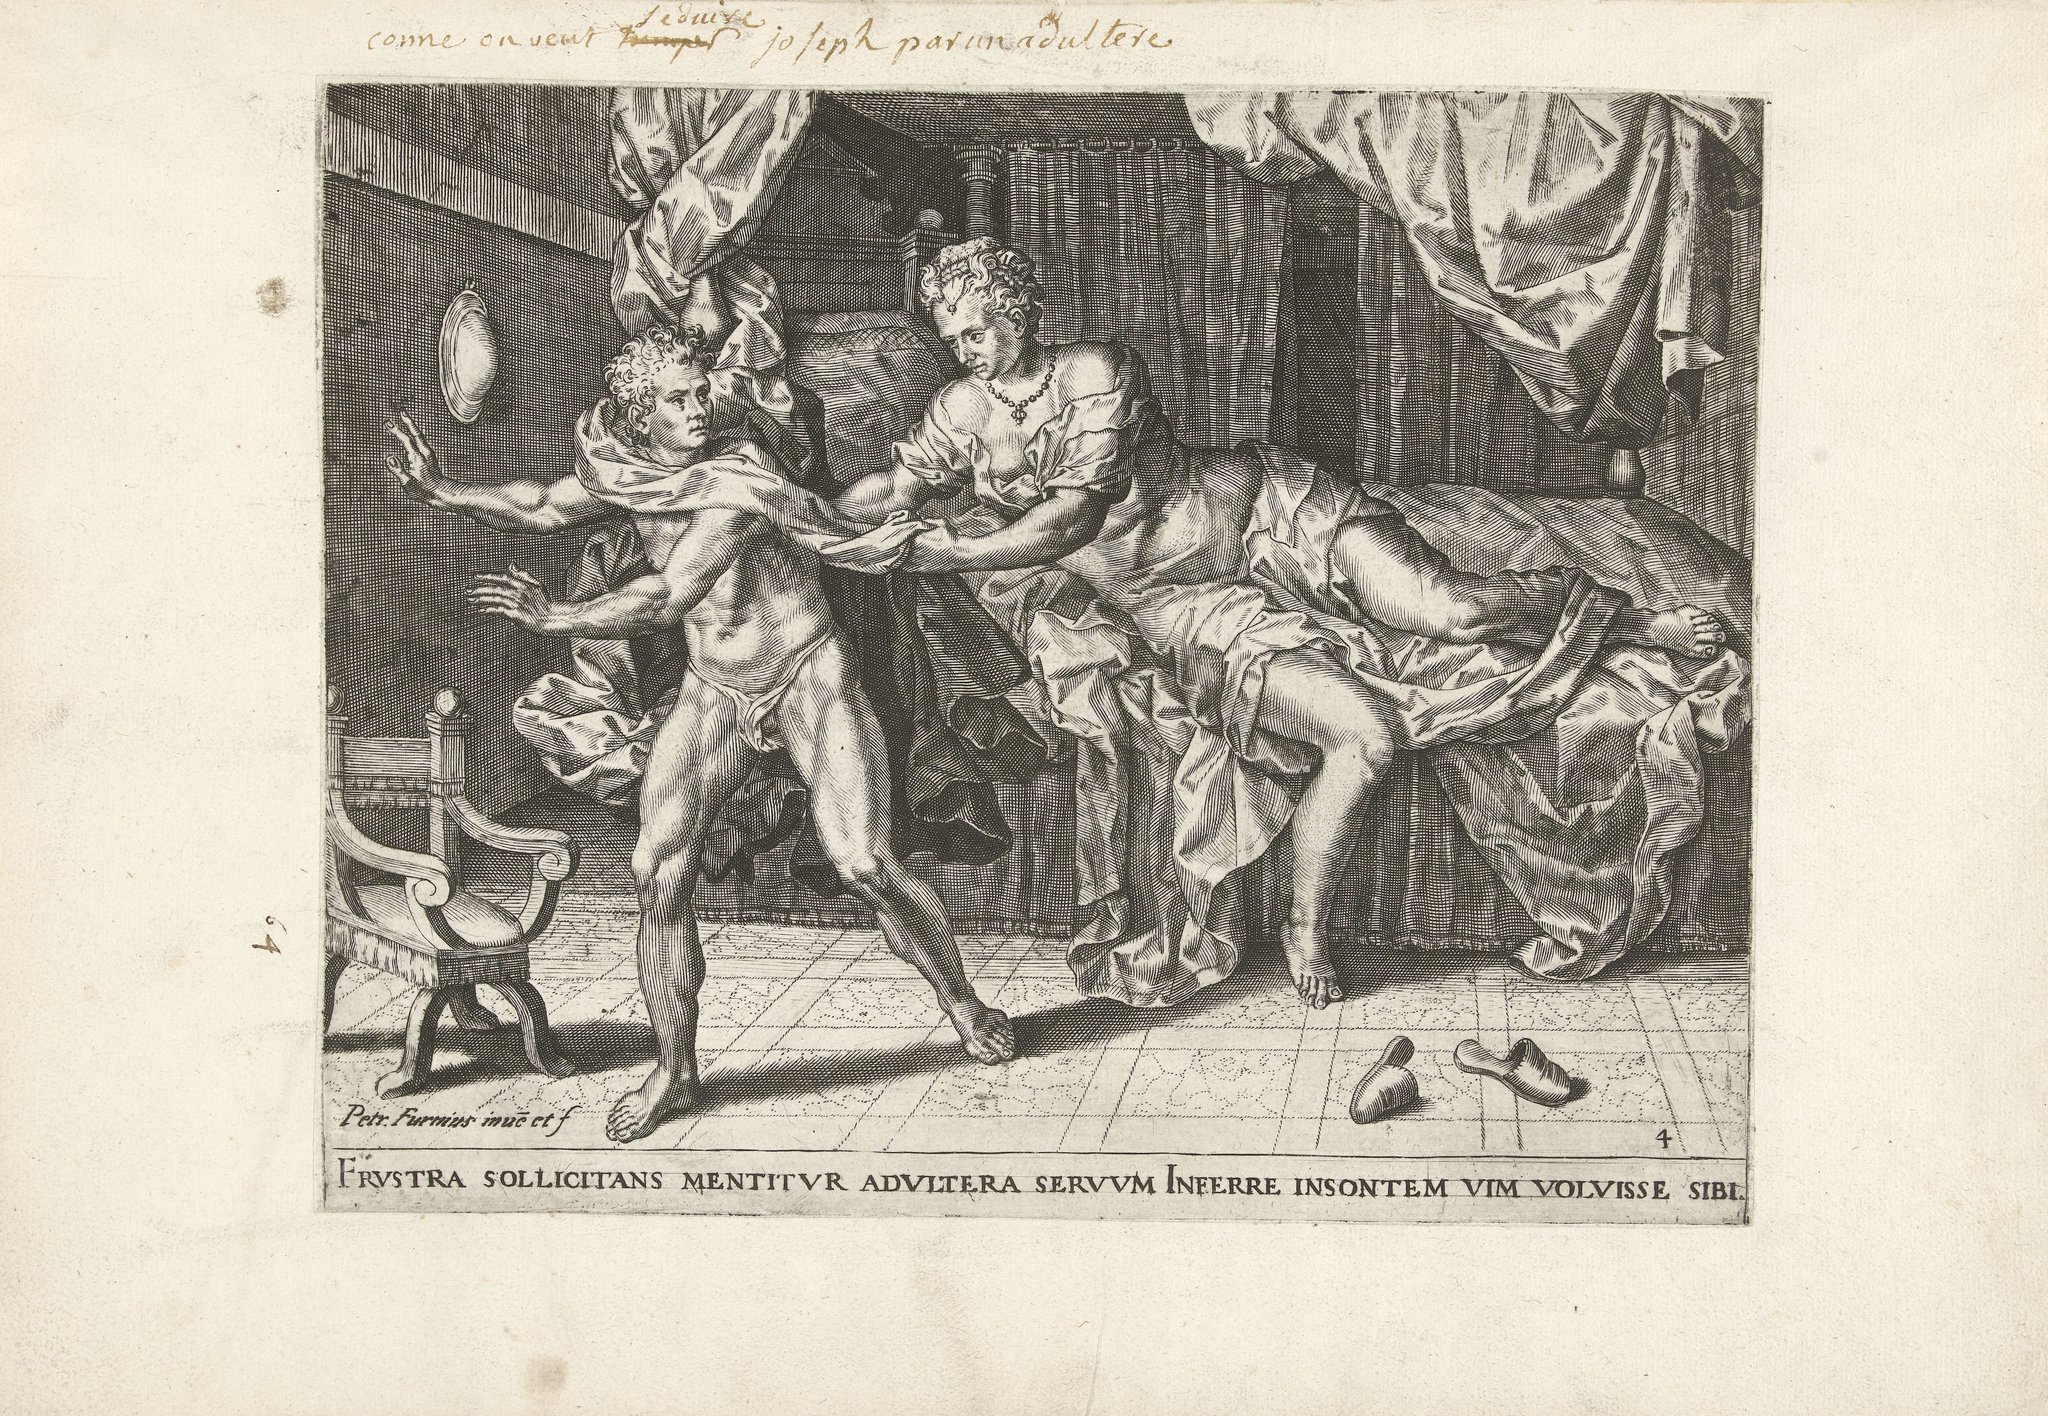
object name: print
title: Geschiedenis van Jozef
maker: pieter jalhea furnius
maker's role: print maker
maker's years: 1540-1626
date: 1572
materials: paper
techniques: engraving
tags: potiphar's wife catches joseph by his robe, usually while lying in bed; joseph escapes leaving his cloak behind in her hands (possibly with a naked child lying in a crib), bed with tester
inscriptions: collector's mark: Lugt 2228, number: ‘64’, inscription: ‘comme on veut seduire joseph par une adultere"’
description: De vrouw van Potifar ligt in een hemelbed en probeert Jozef ervan te weerhouden om weg te gaan door hem aan zijn mantel terug te trekken. Onder de voorstelling staat een regel tekst in het Latijn, rechtsonder genummerd: 4. De prent maakt deel uit van een serie prenten over het leven van Jozef.